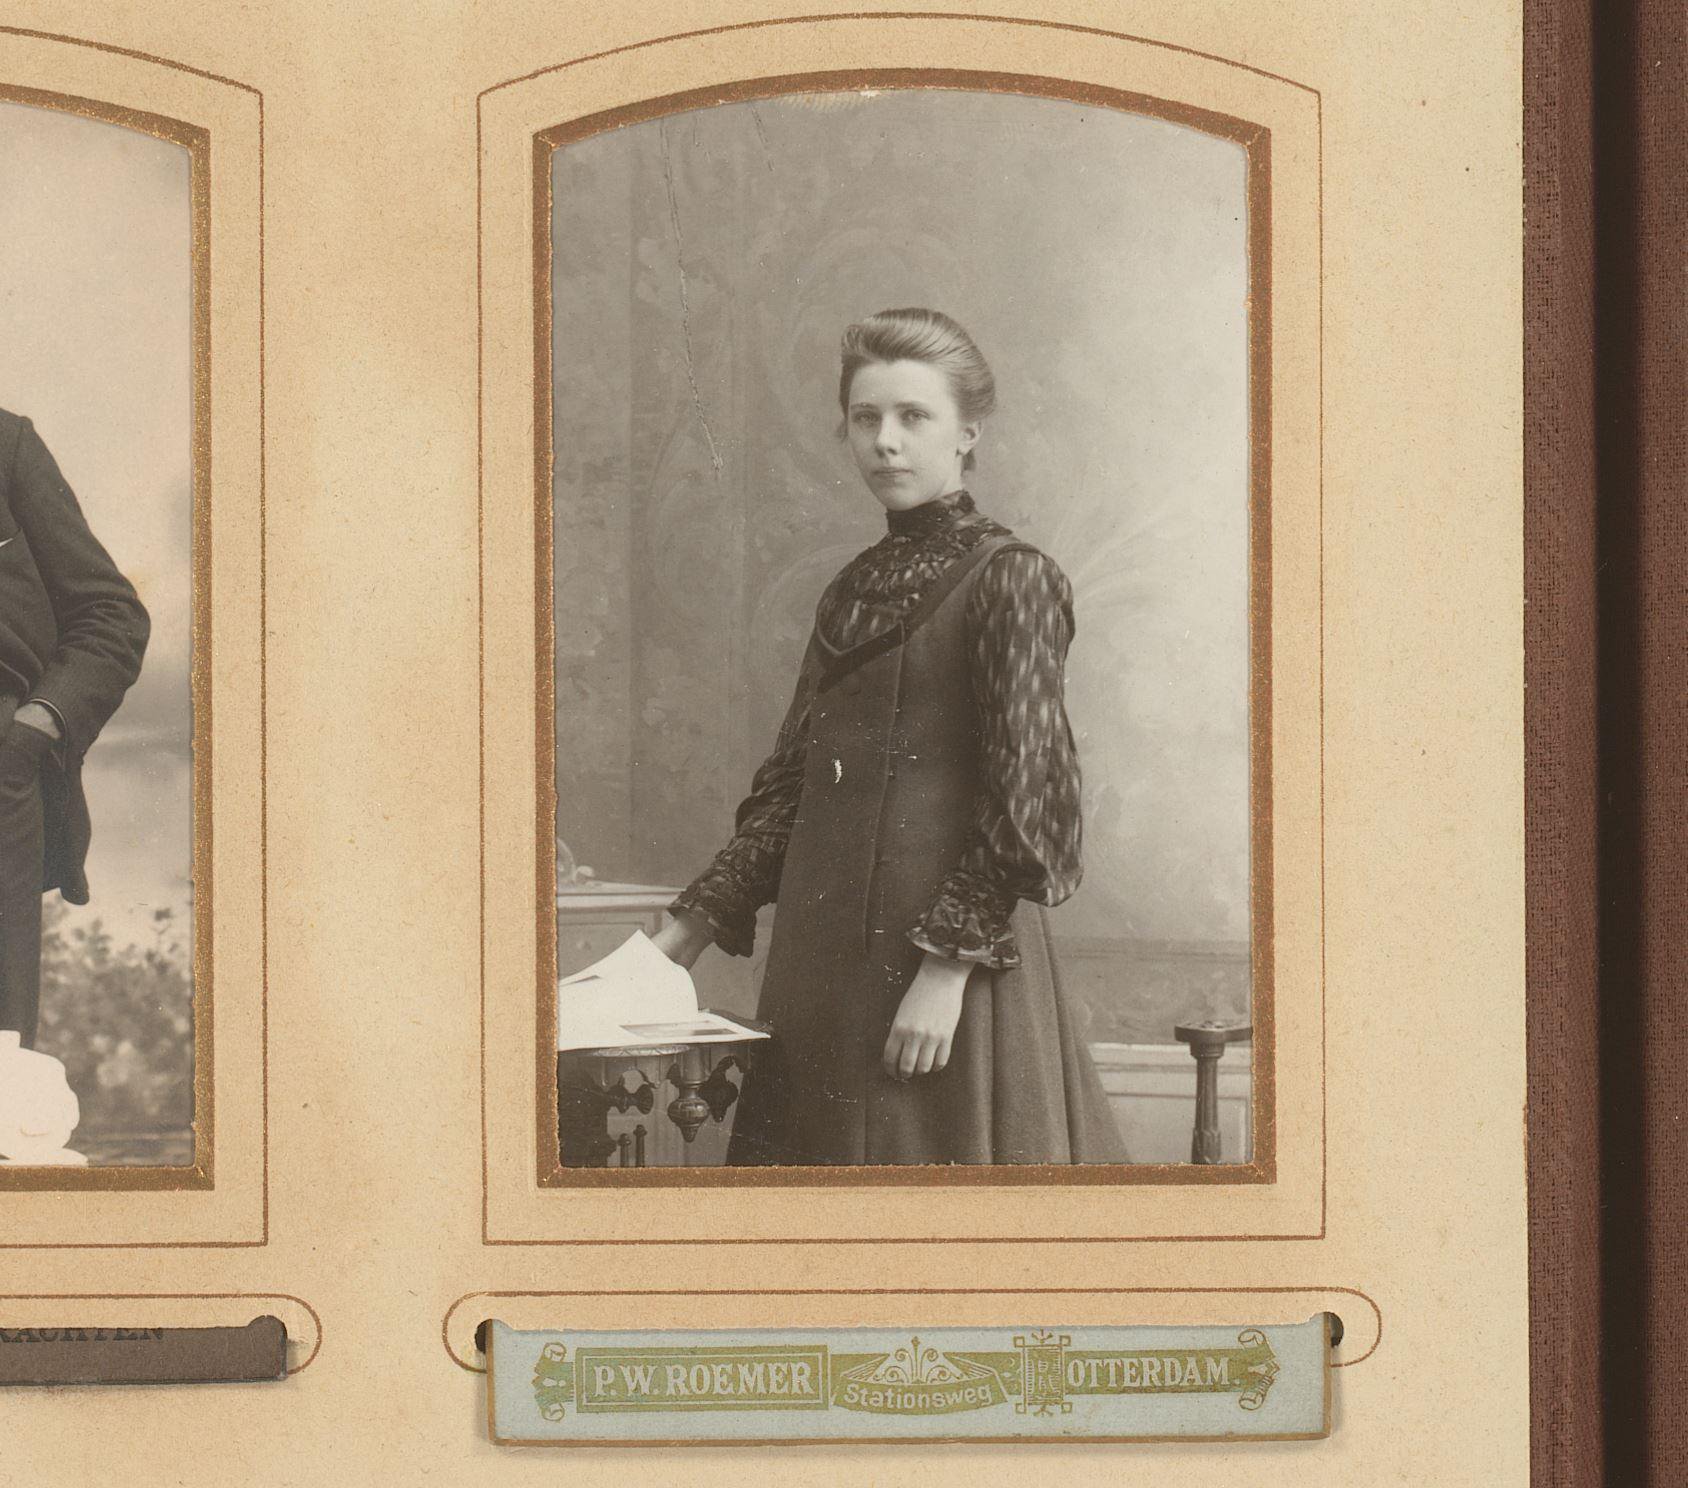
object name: carte de visite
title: Portret van een jonge vrouw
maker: pieter wilhelmus roemer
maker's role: fotograaf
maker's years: 1838-1924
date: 1887-1910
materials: cardboard, photographic support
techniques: collodion silver print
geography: rotterdam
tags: adolescent, young woman, maiden, historical persons - bb - woman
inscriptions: inscription: ‘P.W. Roemer/ Stationsweg/ Rotterdam’